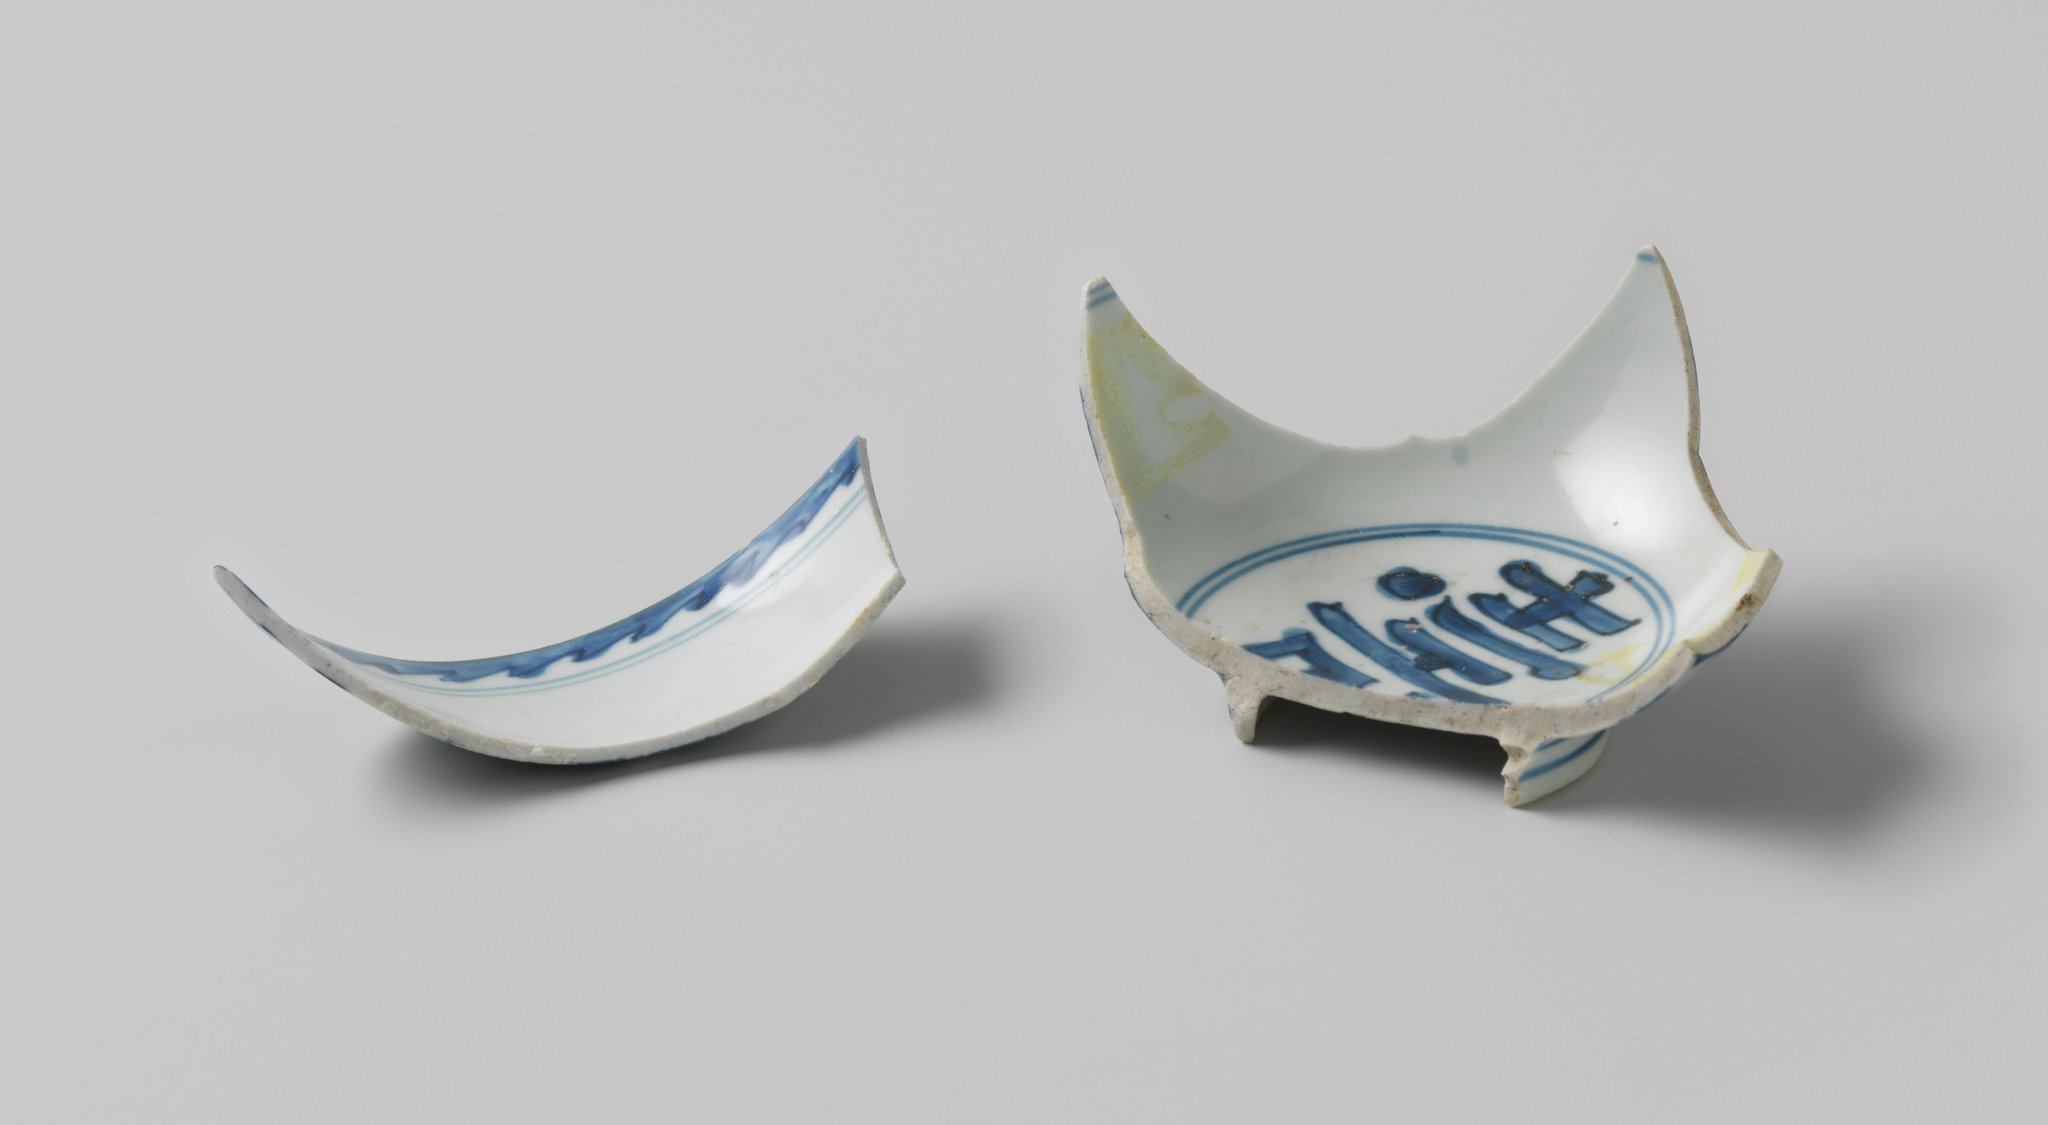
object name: sherd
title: Scherven van kommen uit V.O.C.-schip de 'Witte Leeuw'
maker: Anonymous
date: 1613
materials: porcelain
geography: jingdezhen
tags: verenigde oostindische compagnie, sint-helena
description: A bowl. The cobalt blue is of a dark purple colour. In the centre the character for a long life: shou is drawn, encircled by a double band. On the lip-rim a stylized wave band is drawn. The outside wall is decorated with two four-clawed dragons chasing a flaming pearl.